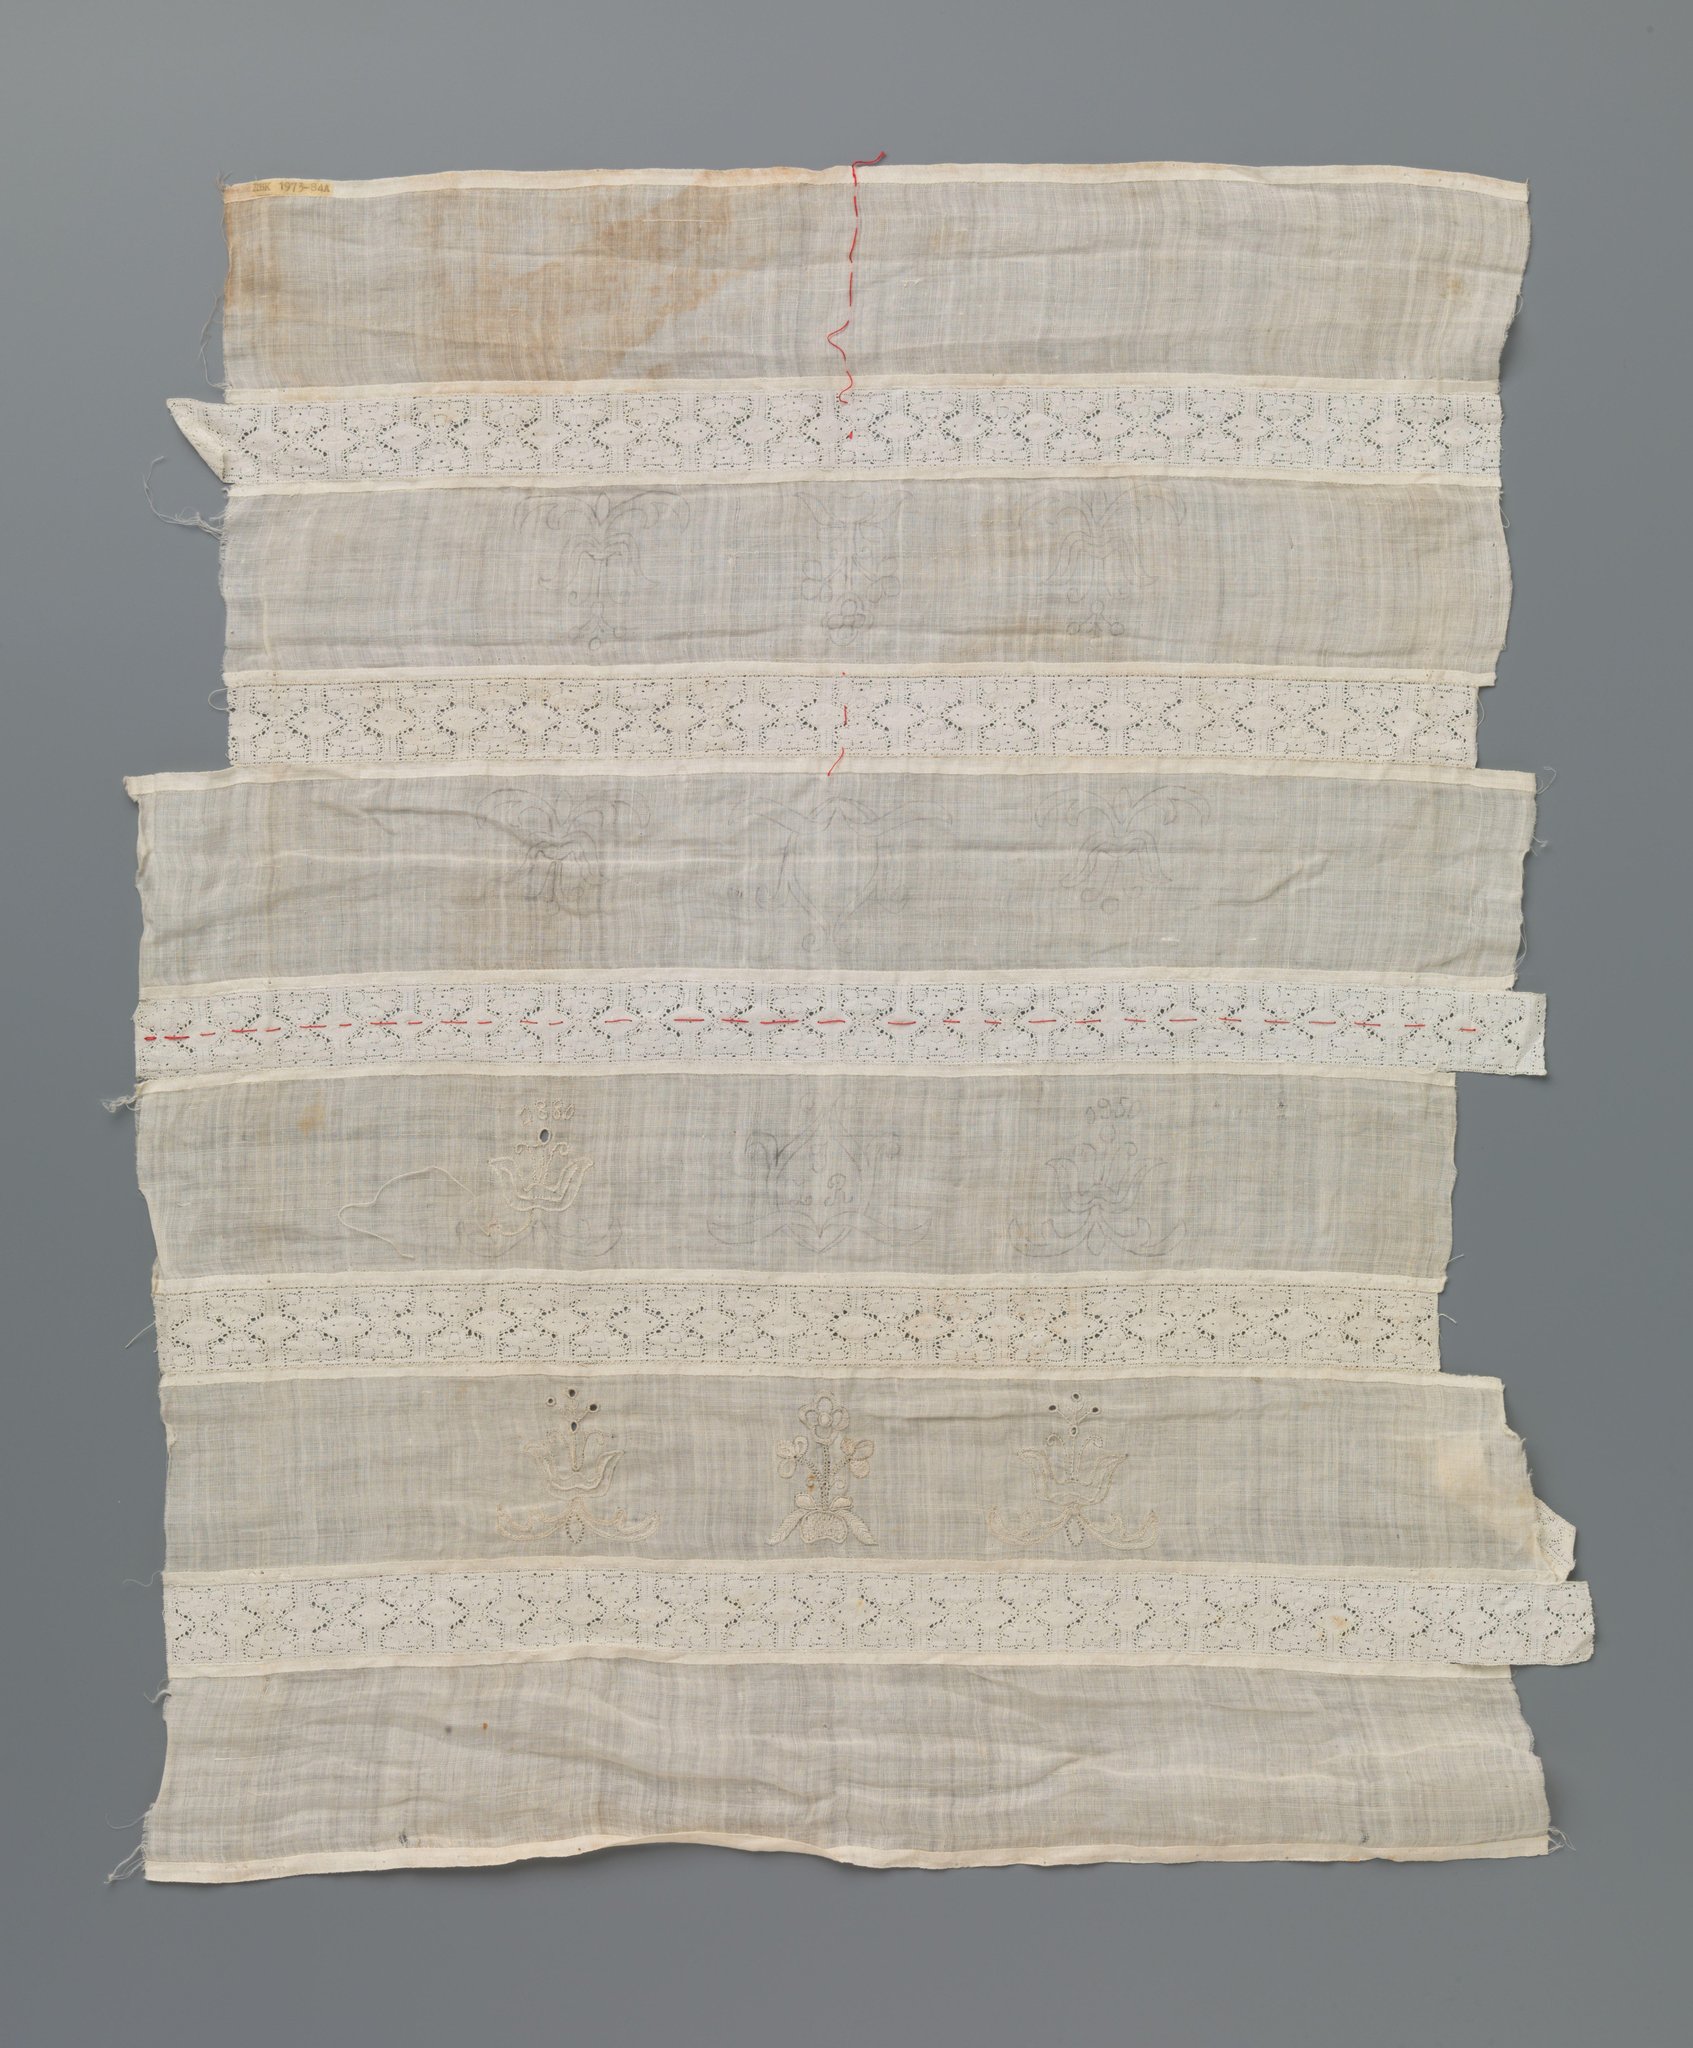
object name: lap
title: Lap batist met borduurlijnen en de initialen I.Z.R en vijf tussenzetsels van kloskant met twee gestileerde gespiegelde bloemen tussen vertikale lijnen en ovalen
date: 1600-1635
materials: linen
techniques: lace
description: Lap van zes stroken fijne linnen batist met vijf tussenzetsels van naturelkleurige Hollandse kloskant. De lap heeft een rechthoekig model. Het kant heeft een patroon dat bestaat uit vertikale rechte lijnen, waartussen twee gestileerde bloemen staan, die over de lengte-as zijn gespiegeld. Op de middenlijn worden de bloemen links en rechts geflankeerd door een liggend spitsovaal, die de vertikale lijn steeds oversnijdt. Het volwerk in linnenslag met uitsparingen wordt door korte vlechtjes bij elkaar gehouden. Op vier van de stroken batist zijn met potlood borduurlijnen getekend, voor het borduren van negentiende eeuwse gestileerde blad- en bloemmotieven en twee spitsovale cartouches. Links en rechts naast één van de cartouches zijn boven de bloemen de jaartallen 1880 en 1950 geschreven. Op één strook is het borduurwerk afgemaakt, op de strook daarboven is met één bloem begonnen, deze is bekroond met het tevens geborduurde jaartal 1880. Bij de andere bloemen en cartouches is niet met het borduurwerk begonnen. Door het midden van de middelste strook kant is in rijgsteek een rode draad gebracht en haaks op deze lijn zijn in over de middenlijn van de lap ook resten van een rode rijgdraad te zien. De boven en onderkant van de lap zijn afgewerkt met een zoompje, de zijkanten zijn niet afgewerkt. In één van de cartouches staan de initialen IZR, het zijn de initialen van Iuud Zweers-Roelvink, zij was de vriendin van mevrouw Pierson-Muysken, die is begonnen met het borduurwerk.